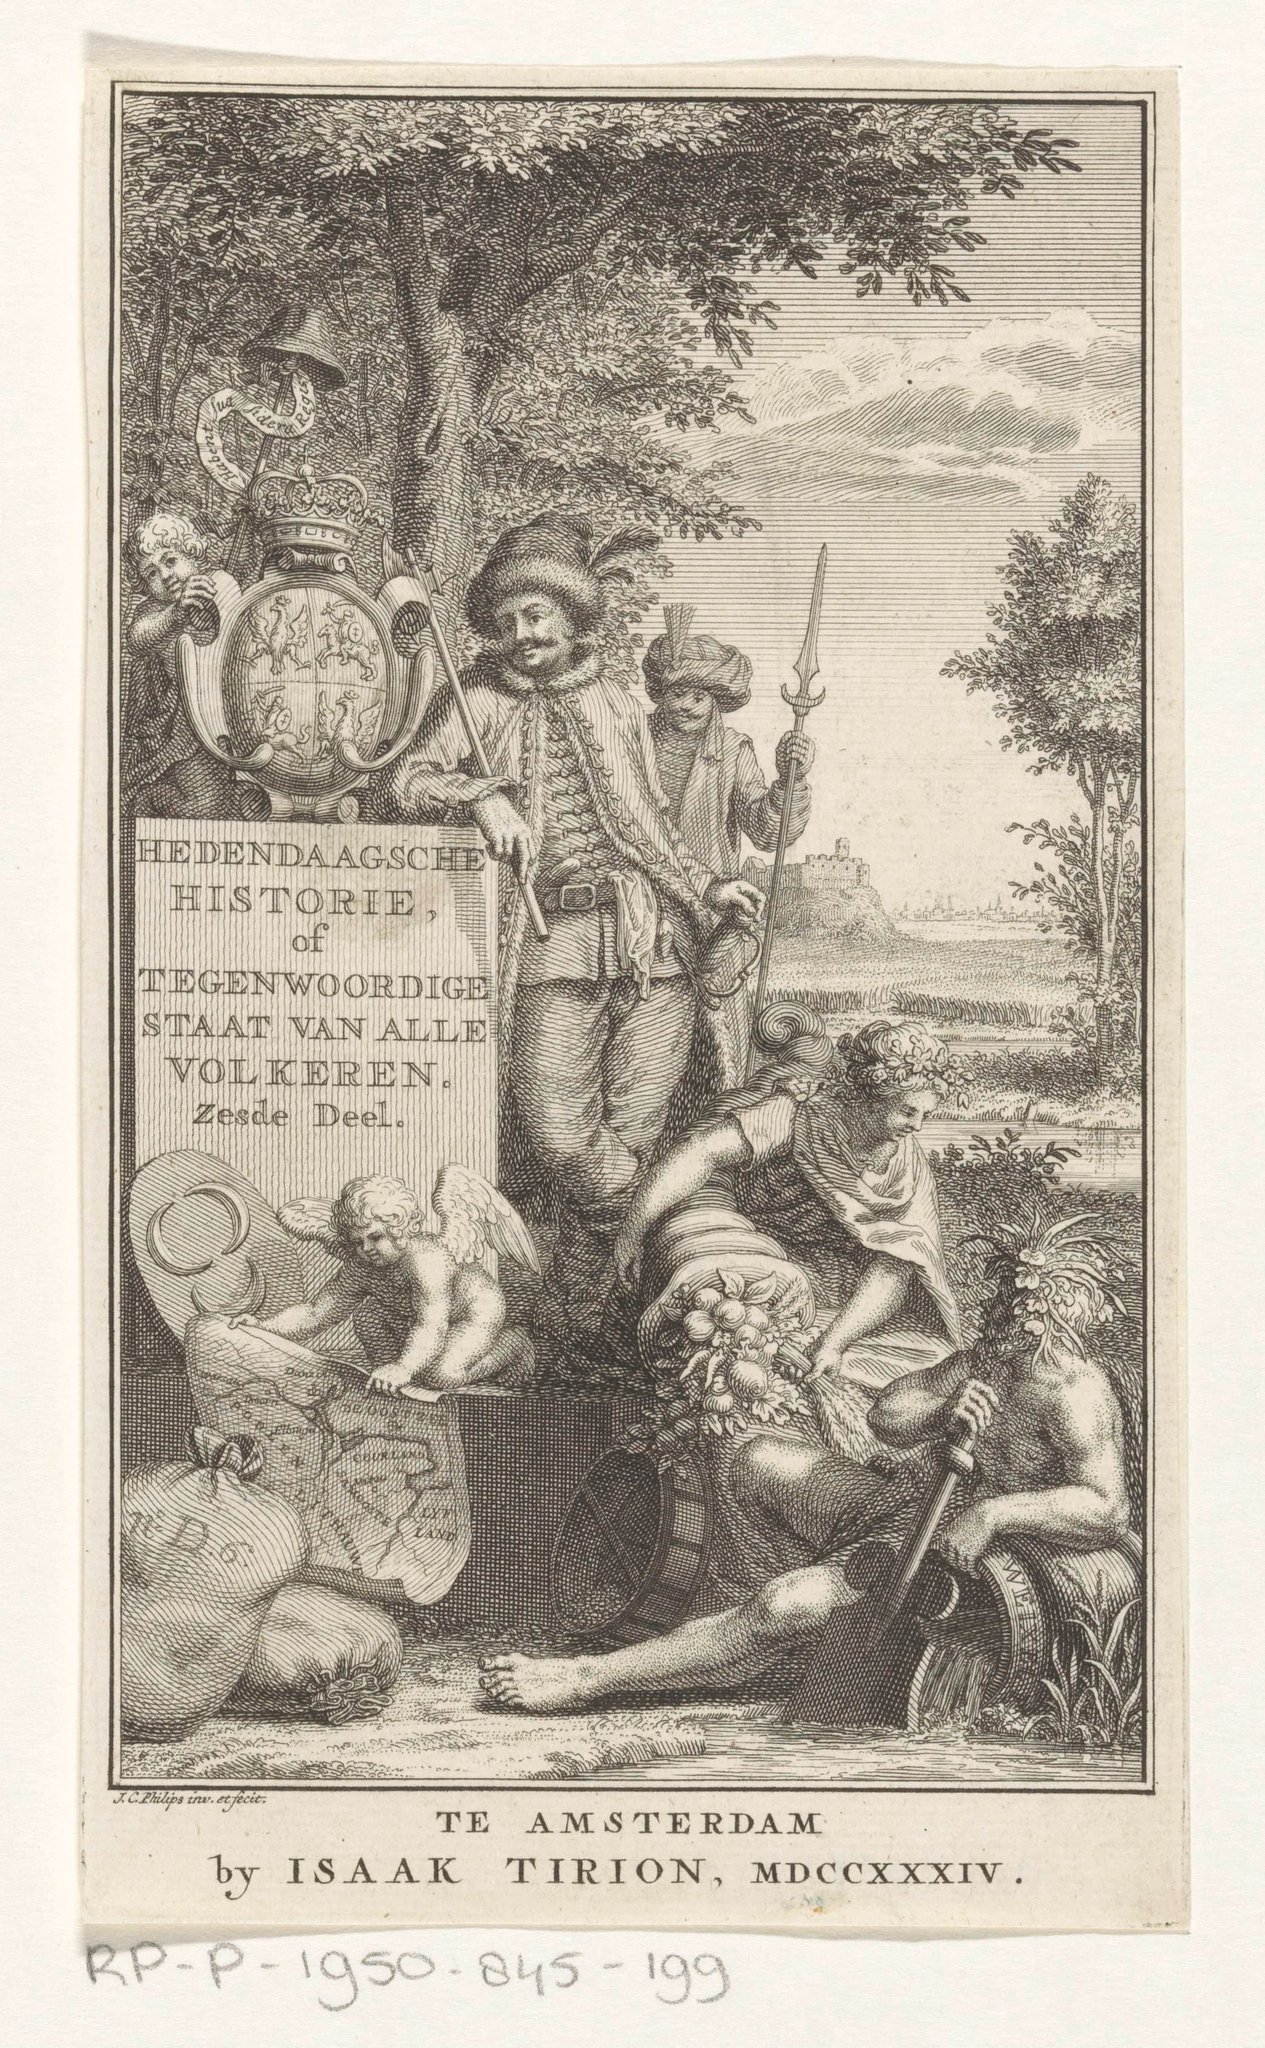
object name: print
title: Titelpagina voor: Thomas Salmon, Hedendaagsche historie of tegenwoordige staat van alle volkeren, VI Deel, 1734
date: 1734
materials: paper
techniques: engraving, etching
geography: amsterdam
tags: europeans, 'cornucopia', horn of plenty, maps, atlases, river-gods, poland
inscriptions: collector's mark: Lugt 2228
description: Een man met muts en bijl staat geleund tegen een voetstuk met boektitel. Achter hem een man met tulband. Op het voetstuk een gekroond wapenschild waarachter een putto met vrijheidshoed. Daarvoor zit een putto naast het wapen van Turkije met een kaart van Polen en Litouwen. Rechts buigt een vrouw met hoorn des overvloeds voorover richting een riviergod die de Poolse rivier de Wisla (Weixel) personifieert.